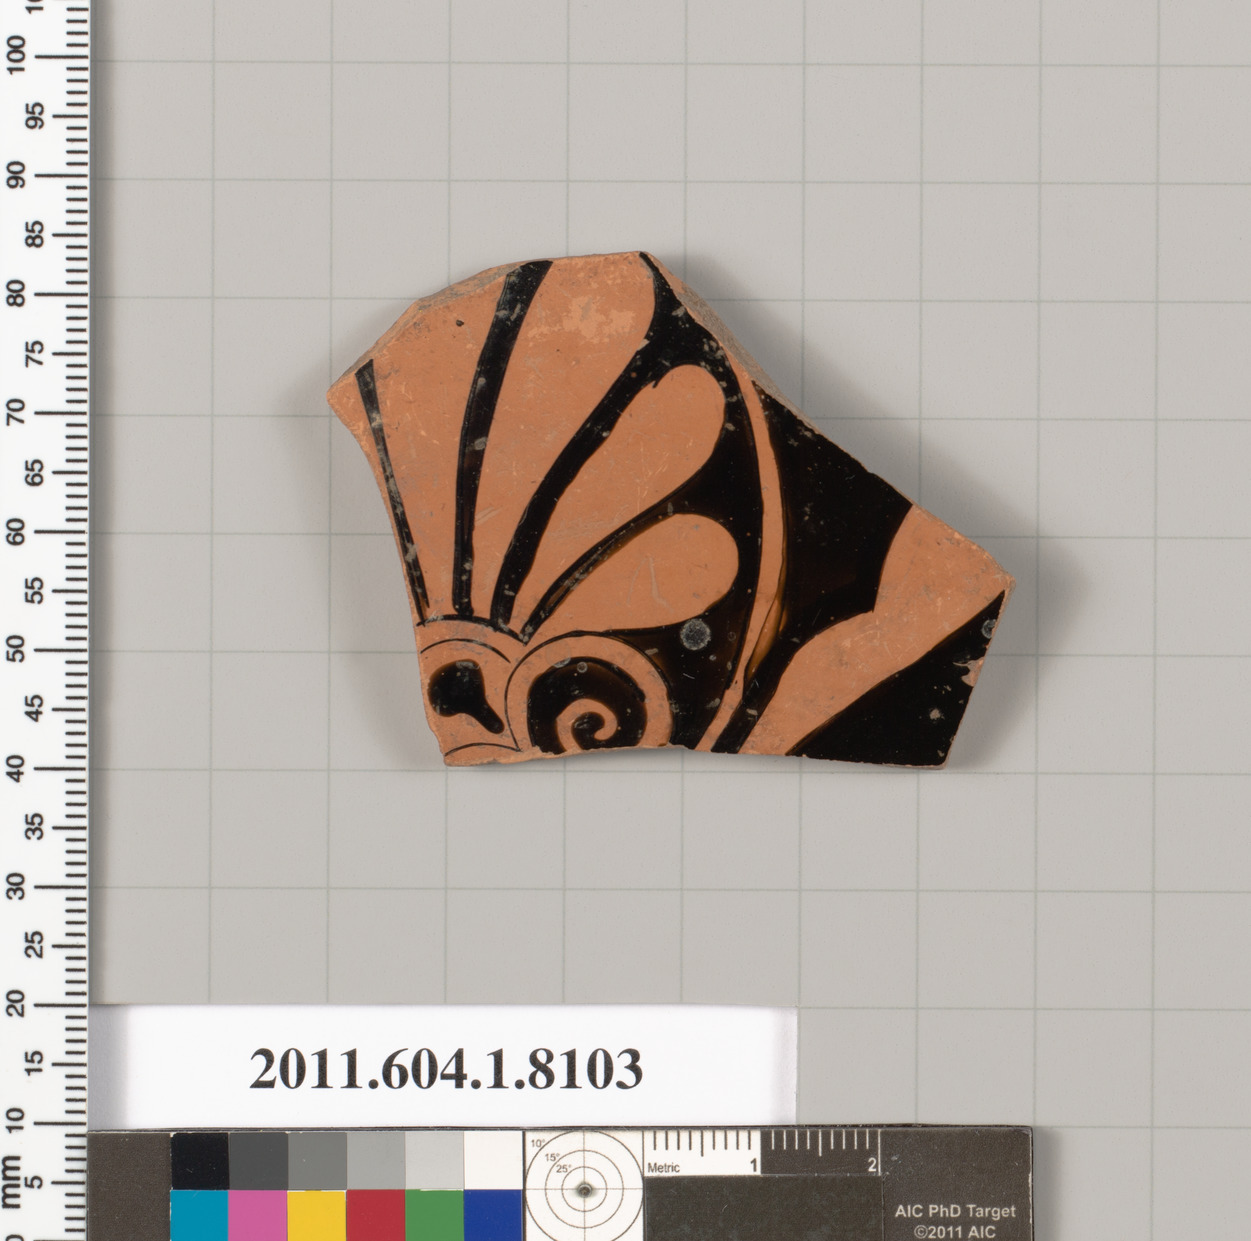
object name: kylix fragment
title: Terracotta fragment of a kylix (drinking cup)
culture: greek, attic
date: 520-510 BCE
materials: terracotta